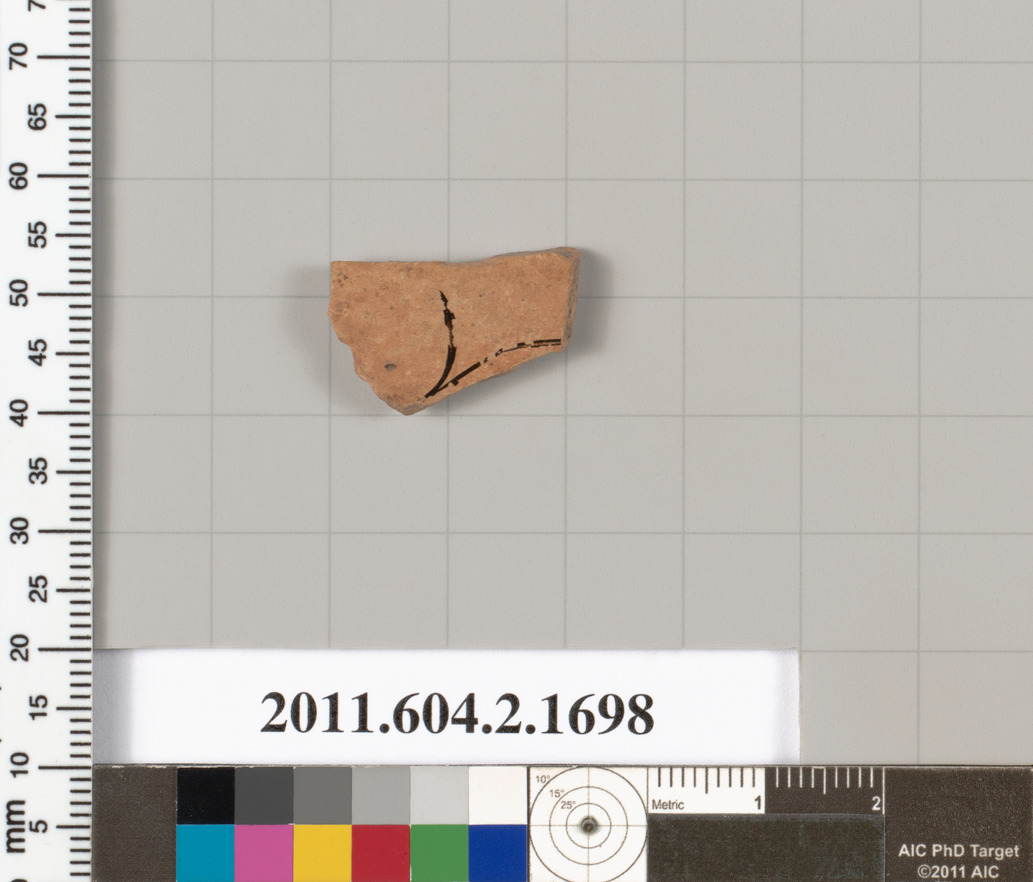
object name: skyphos fragment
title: Terracotta fragment of a skyphos (deep drinking cup)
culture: greek, attic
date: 460-440 BCE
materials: terracotta